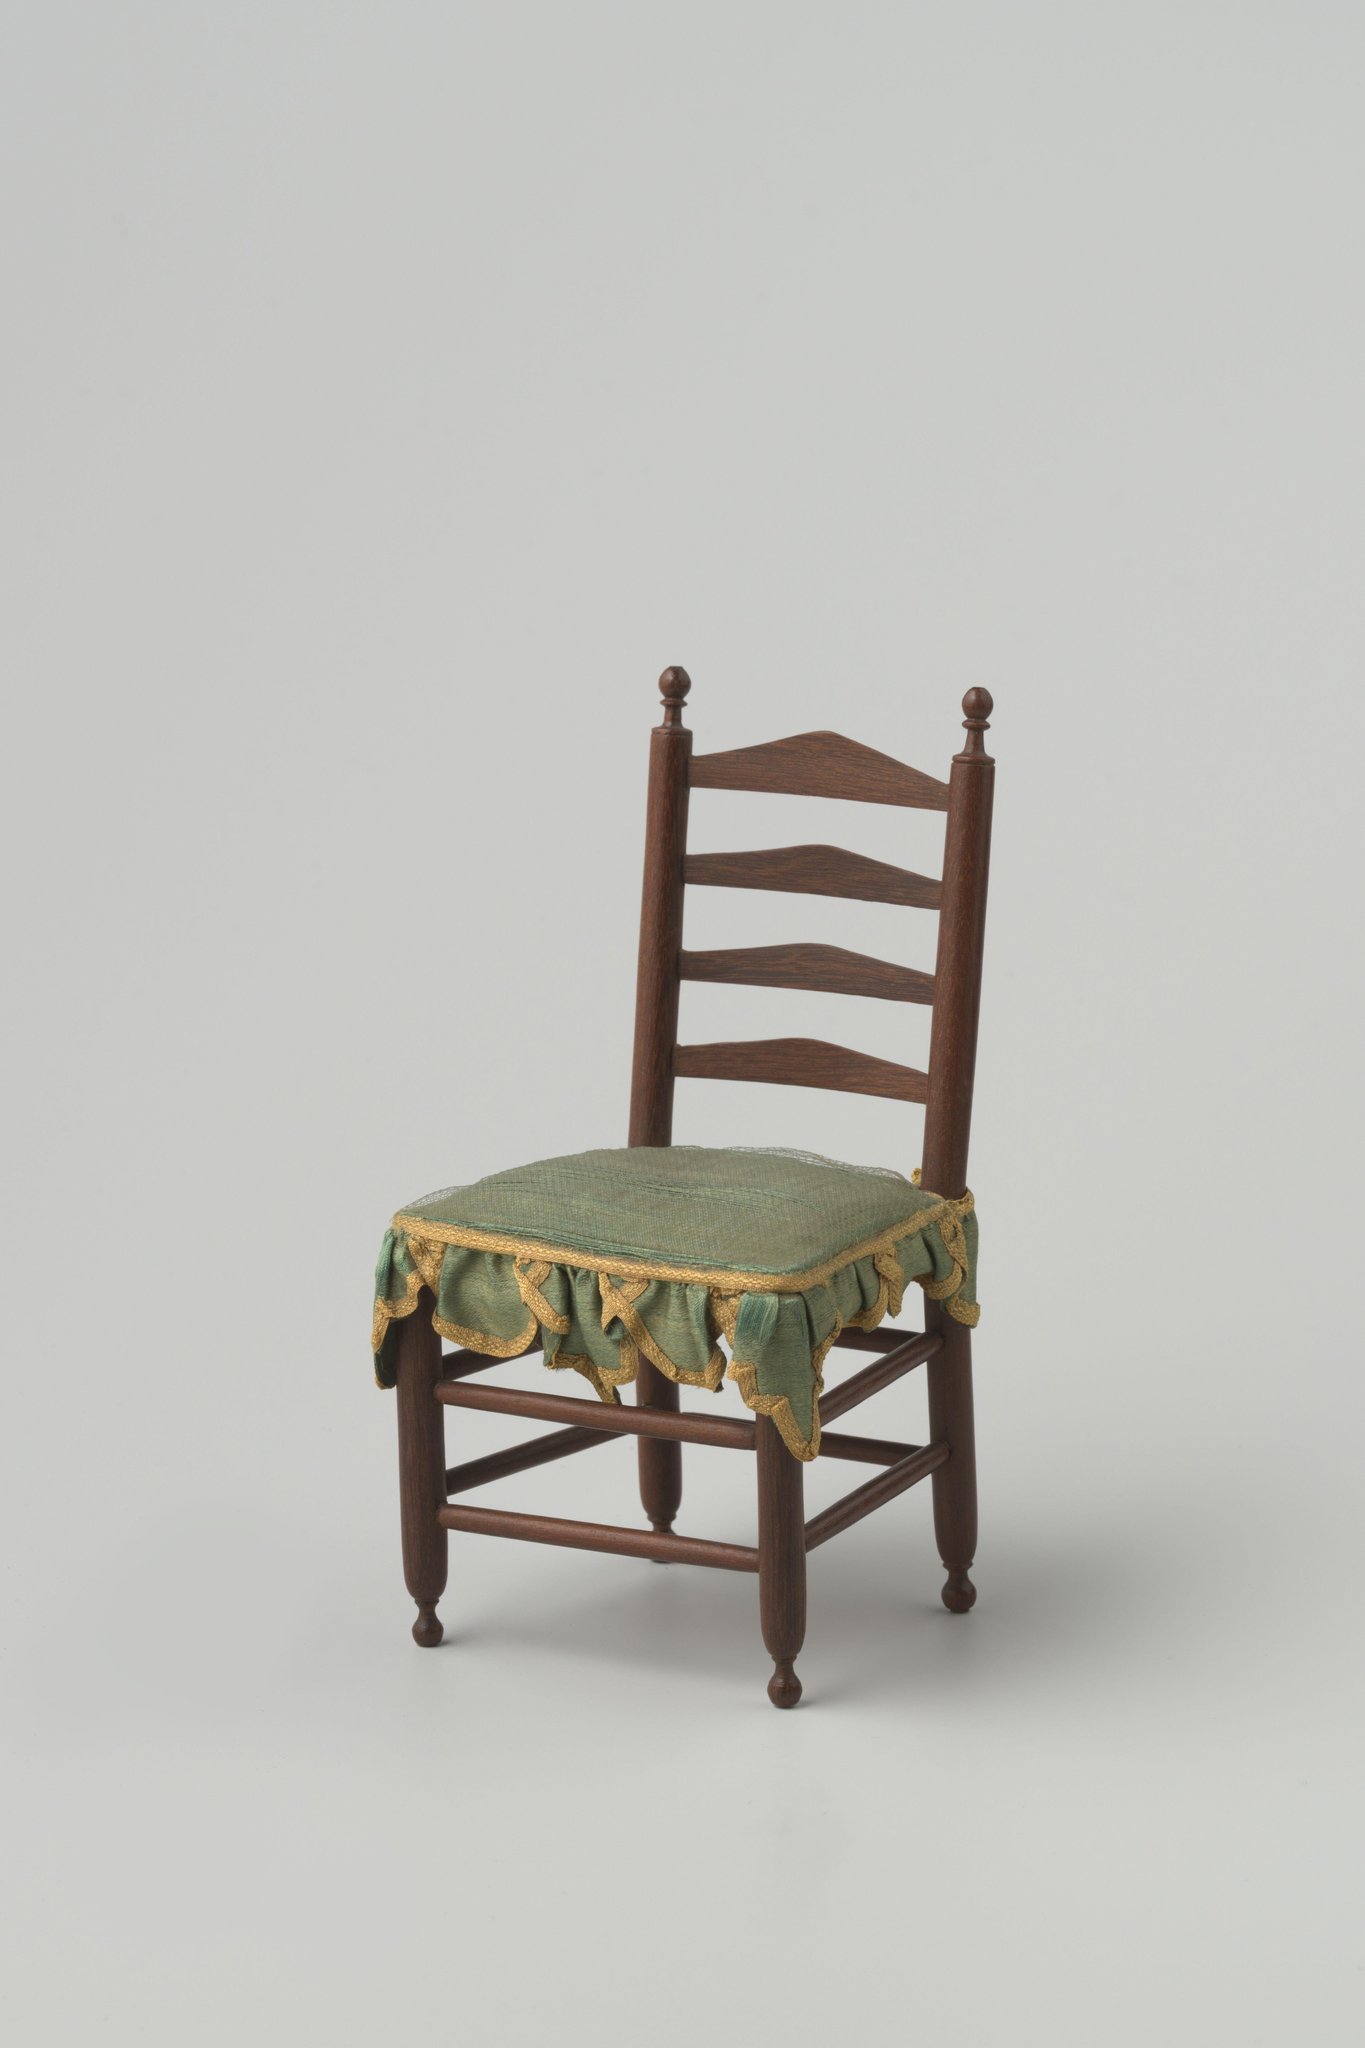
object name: chair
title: Knopstoel vervaardigd van hardhout, met gladde gedraaide stijlen en dwarsregels, voorpoten en achterstijlen eindigend in fijn gedraaide knoppen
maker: Anonymous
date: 1690-1710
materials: wood, silk, fiber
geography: amsterdam